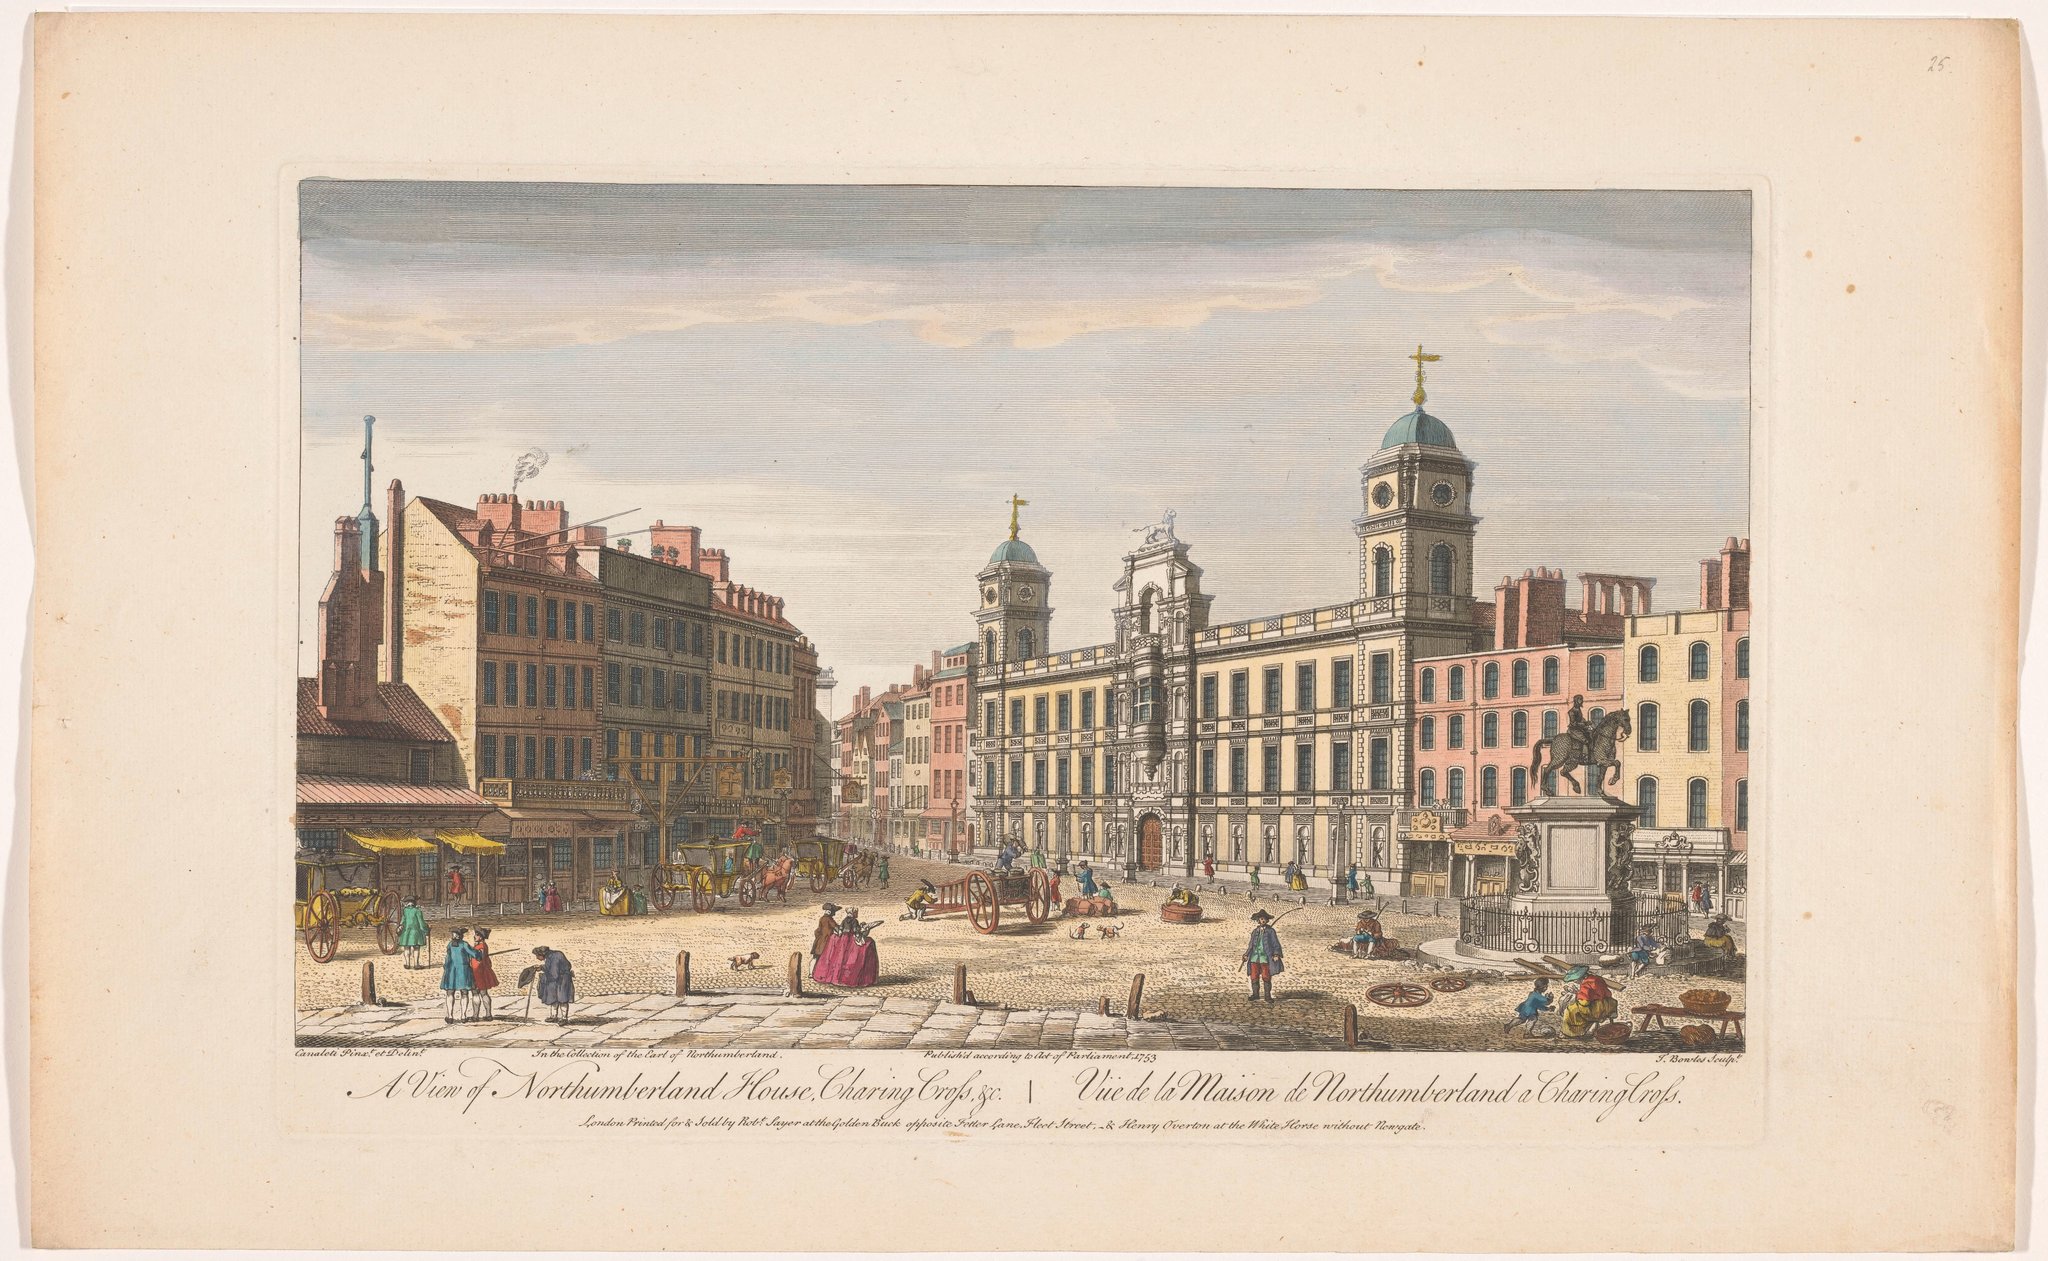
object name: opticaprent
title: Londen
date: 1753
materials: paper, watercolor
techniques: brush, etching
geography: london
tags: civic architecture; edifices; dwellings, street (+ city(-scape) with figures, staffage)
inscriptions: watermark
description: De serie “Londen” bevat 52 prenten met de nummers 1-52, waarvan dit nummer 25 is.